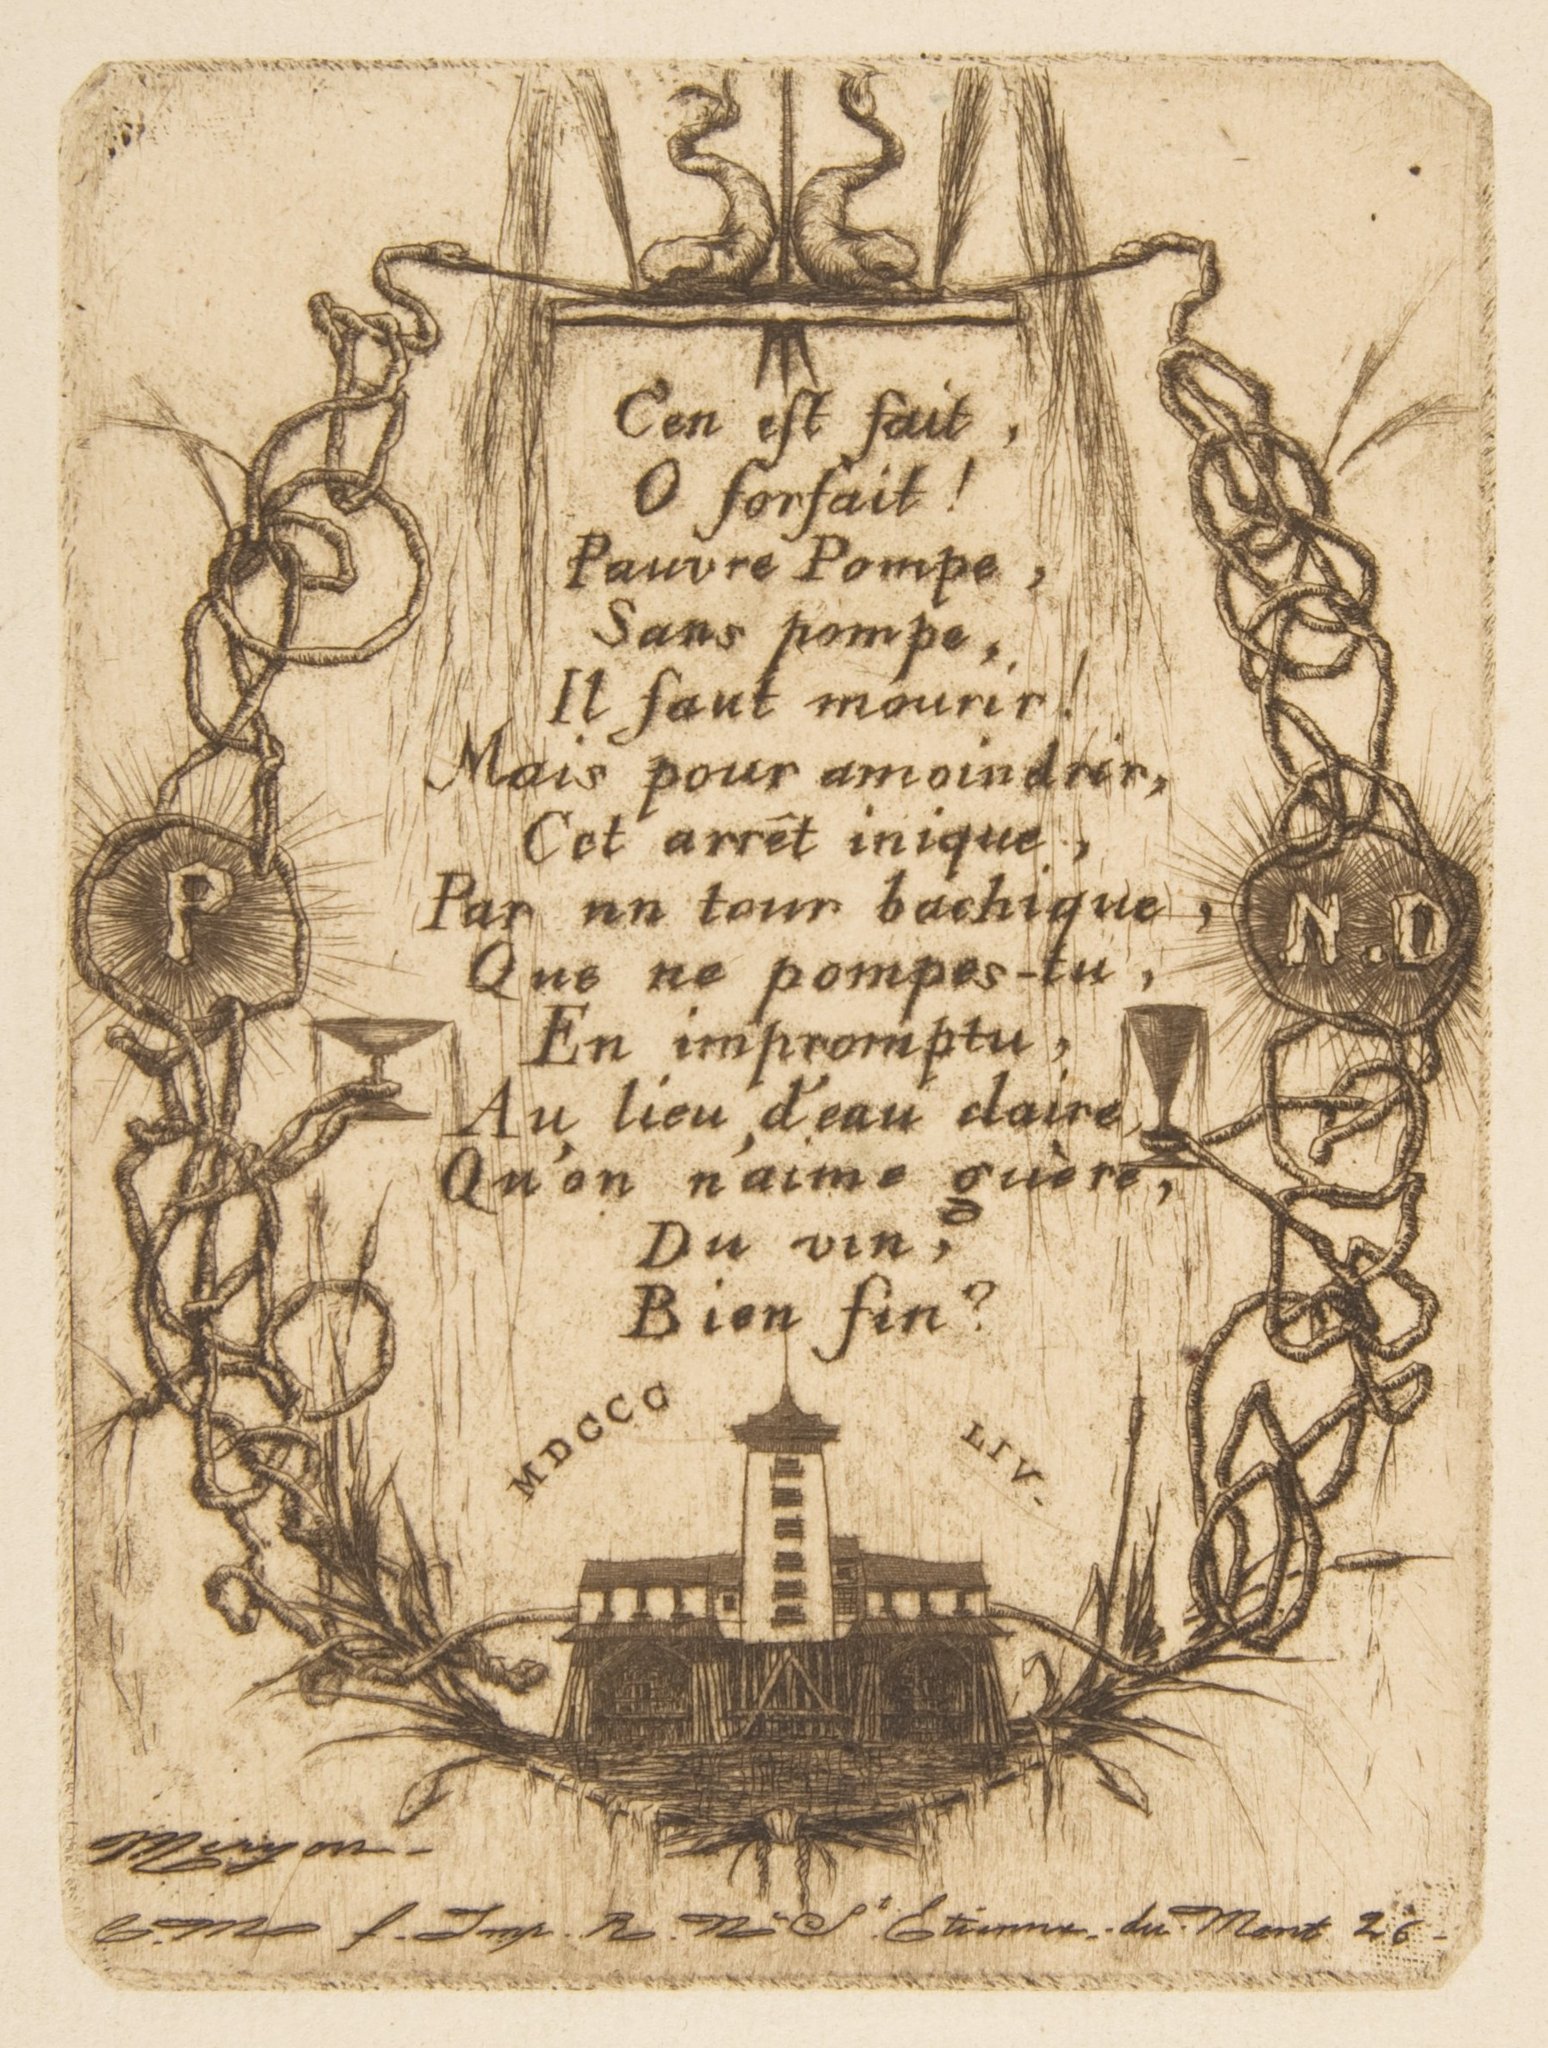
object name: print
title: The Nôtre-Dame Pump (small plate)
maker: charles meryon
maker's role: artist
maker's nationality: french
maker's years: 1821-1868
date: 1854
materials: paper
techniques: etching